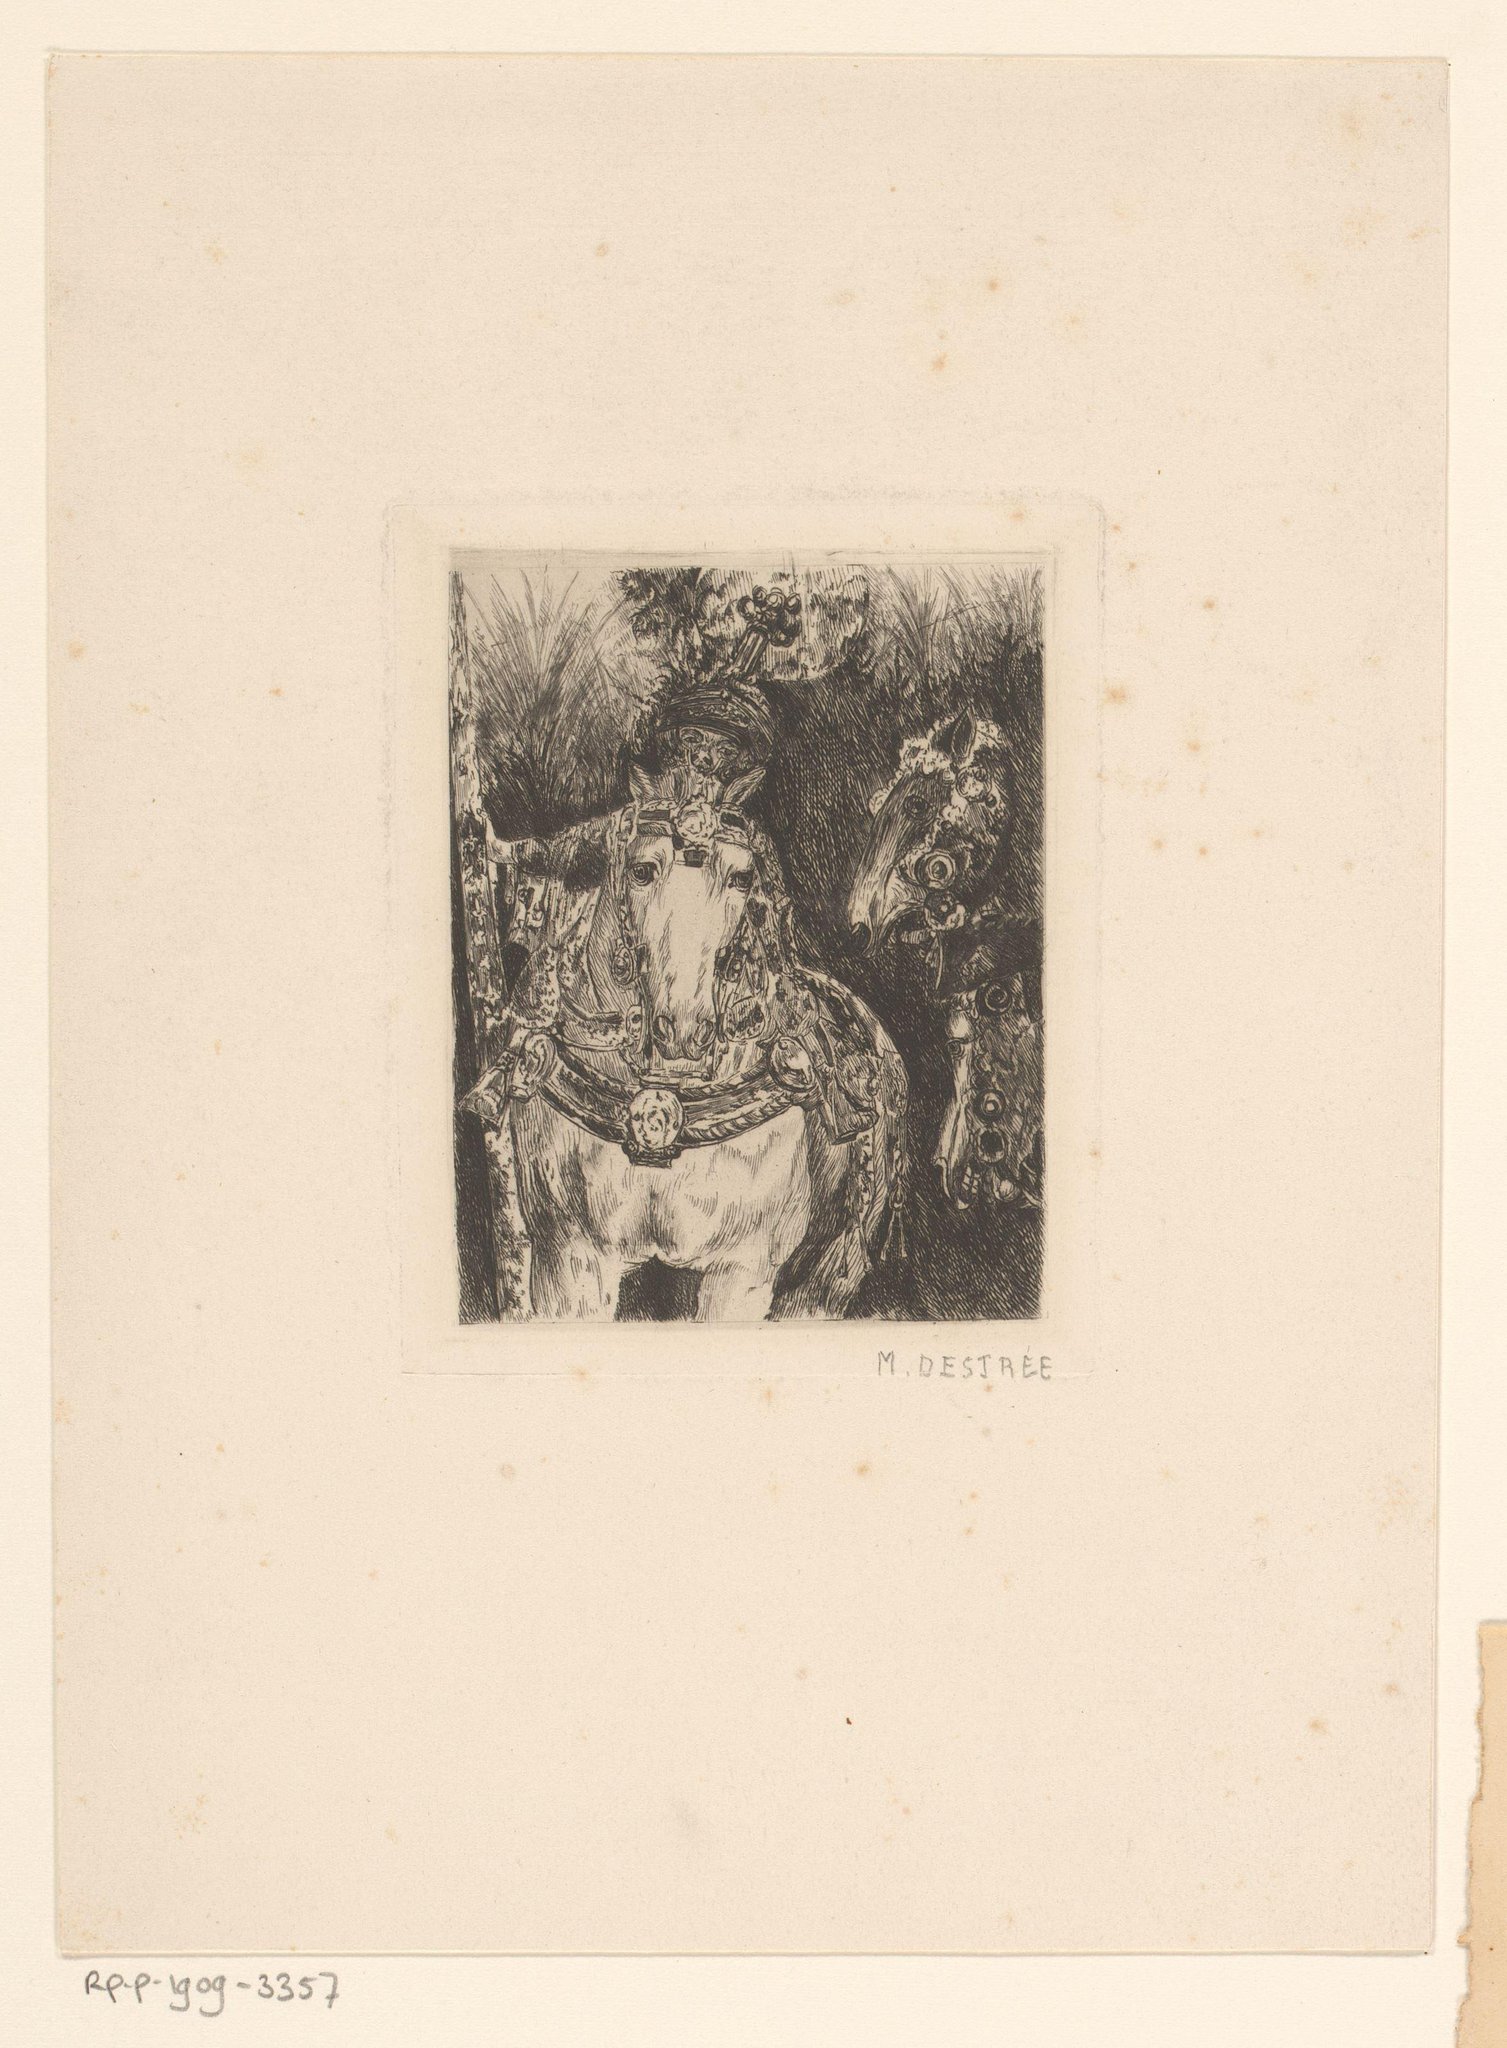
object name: print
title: Ruiter te paard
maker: marie danse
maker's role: print maker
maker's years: 1867-1942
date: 1889-1909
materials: paper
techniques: etching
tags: riding a horse, ass, or mule; rider, horseman, st. george and the dragon: dressed in armour and mounted on a (white) horse he brandishes his sword (his lance lies already broken on the ground); the princess nearby may be shown praying or fleeing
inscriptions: collector's mark: Lugt 2228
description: Prent naar een detail uit het fresco van Pisanello te Verona: St. George en de prinses.